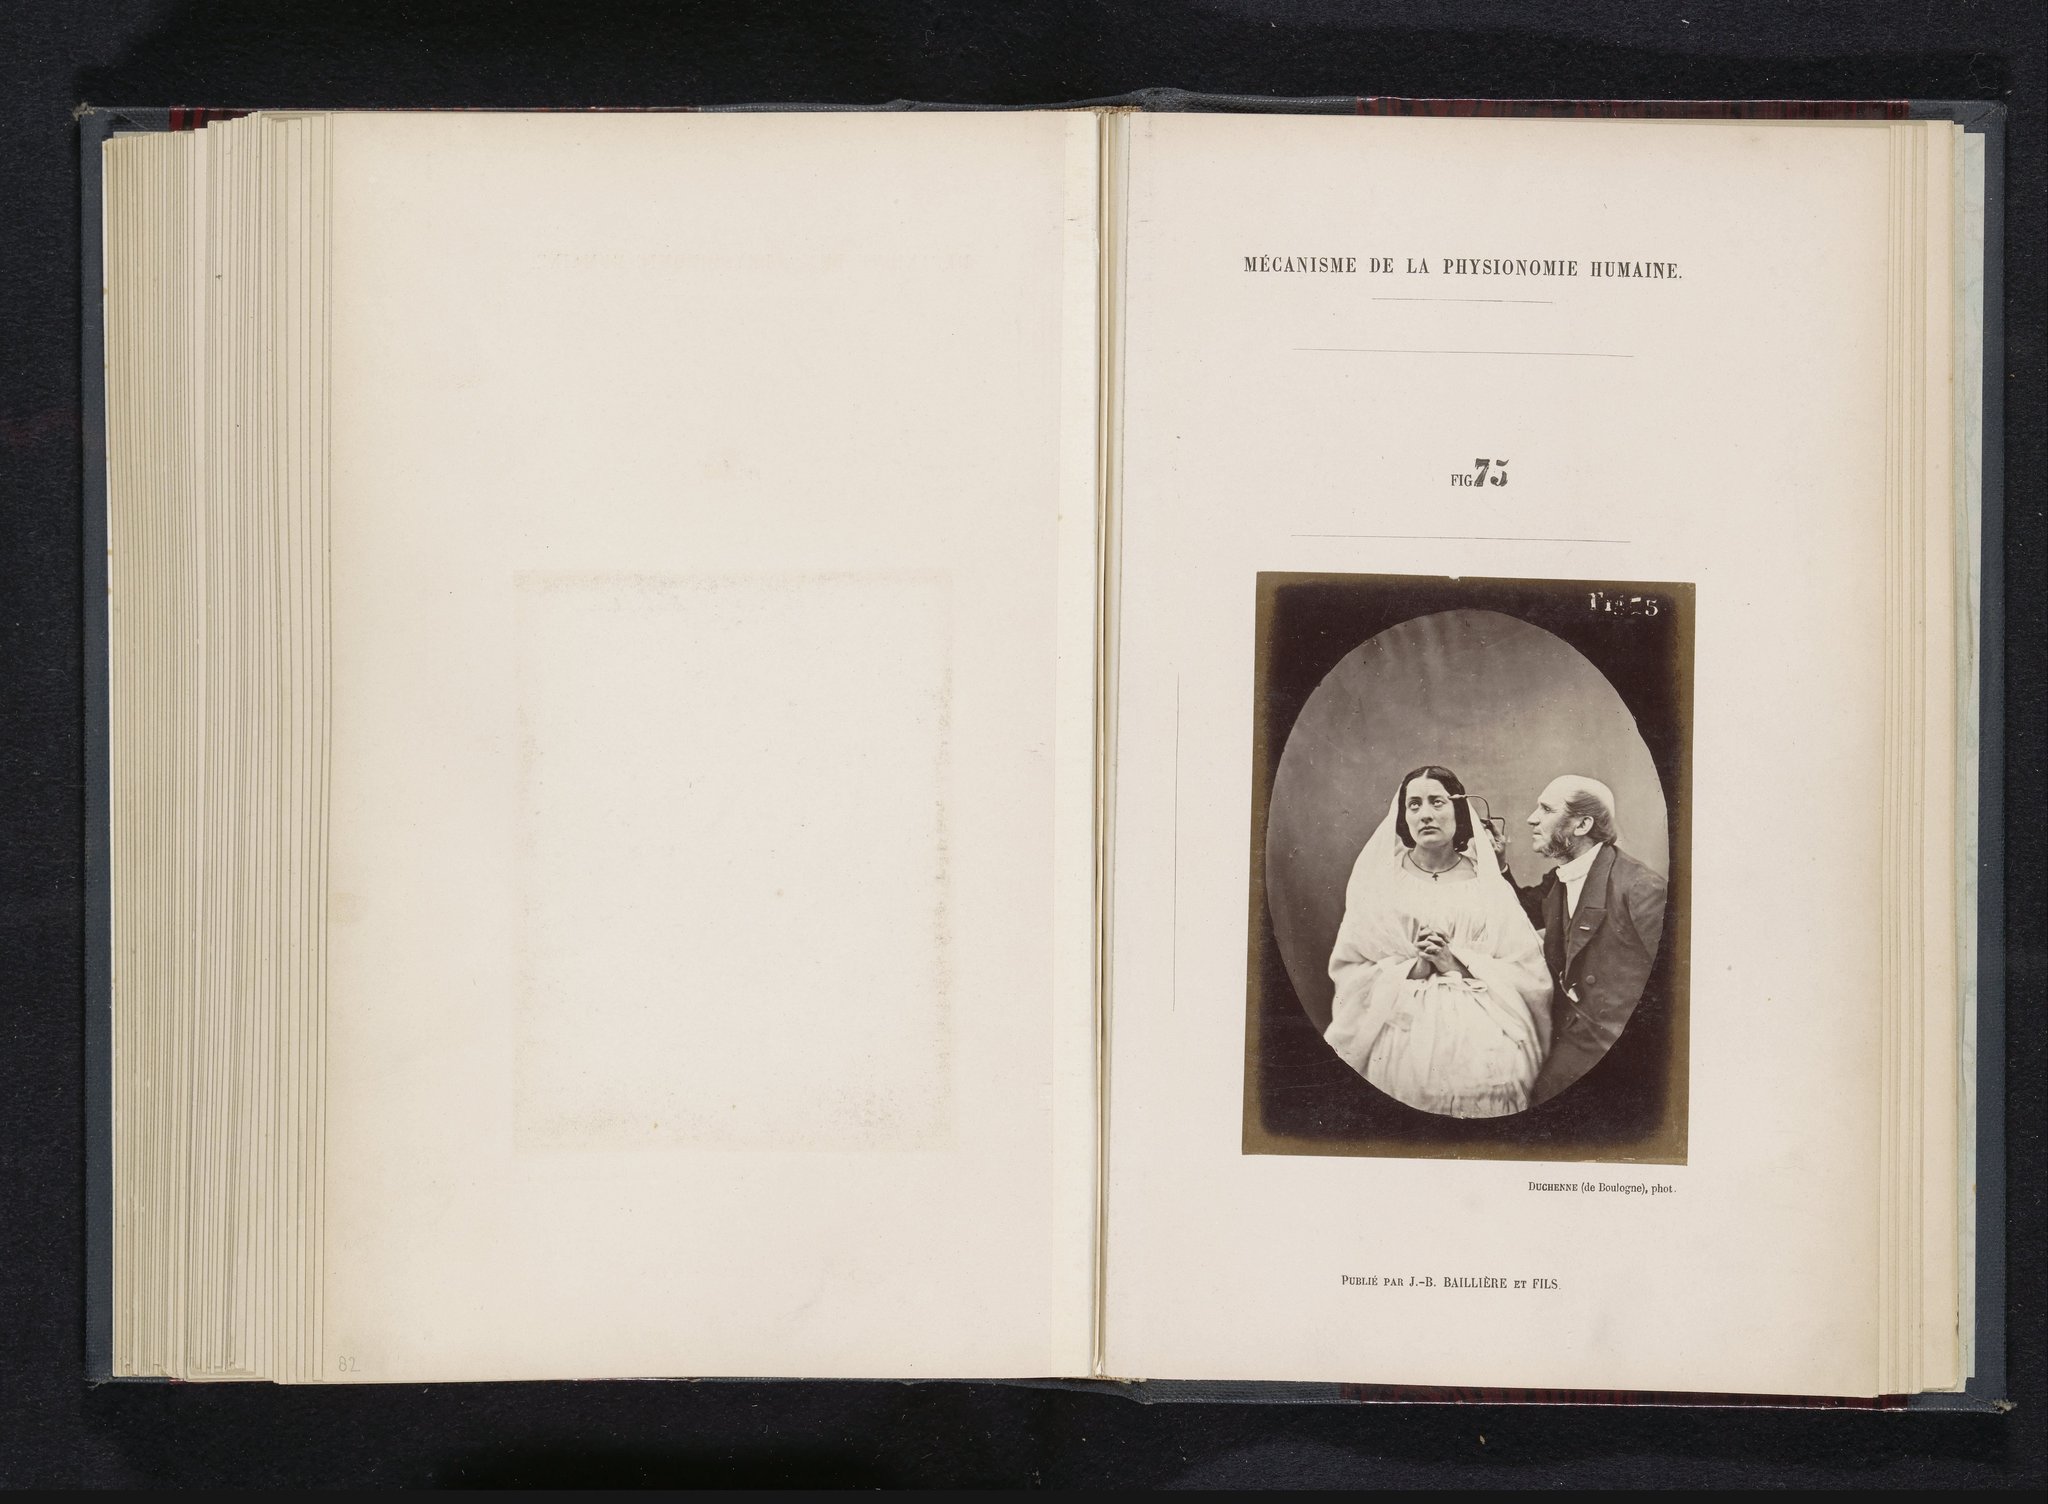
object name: photograph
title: Portret van G.B.A. Duchenne en proefpersoon 'la jeune fille' tijdens elektrostimulatie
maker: guillaume benjamin amand duchenne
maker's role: fotograaf, medicus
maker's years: 1806-1875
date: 1860-1862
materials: paper, photographic support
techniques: albumen print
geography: france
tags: paris, guillaume benjamin amand duchenne, face, adult woman, physiology and anatomy ~ nervous system, neurology, physiology and anatomy, morphology of facial expression, physiognomy, experiment, test ~ science and technology, france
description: Ongenummerde pagina met foto 75 uit Mécanisme de la physionomie humaine ou analyse électro-physiologique de l'expression des passions (Atlas).